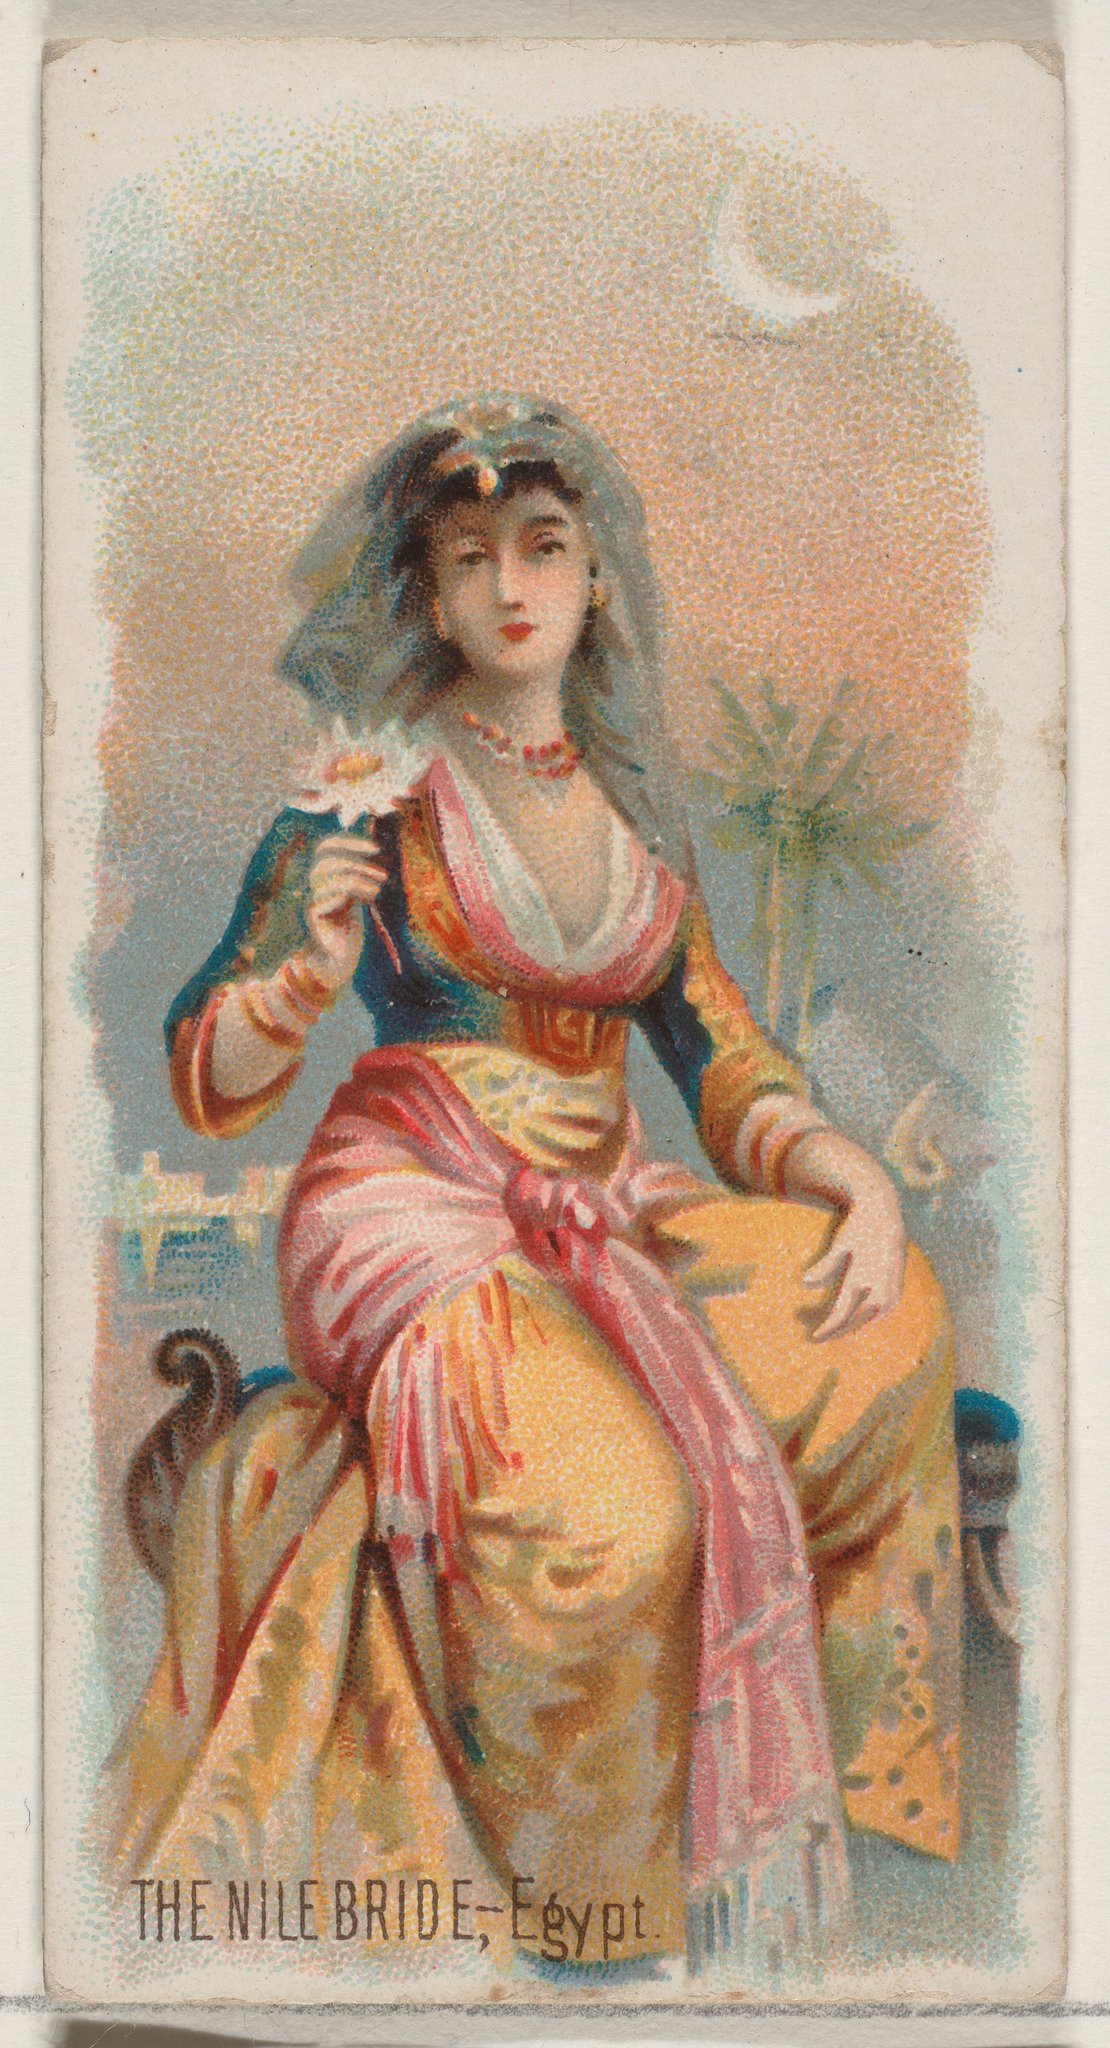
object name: print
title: The Nile Bride, Egypt, from the Holidays series (N80) for Duke brand cigarettes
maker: w. duke, sons & co.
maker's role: publisher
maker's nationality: american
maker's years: 1870-1920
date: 1890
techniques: color lithograph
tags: women